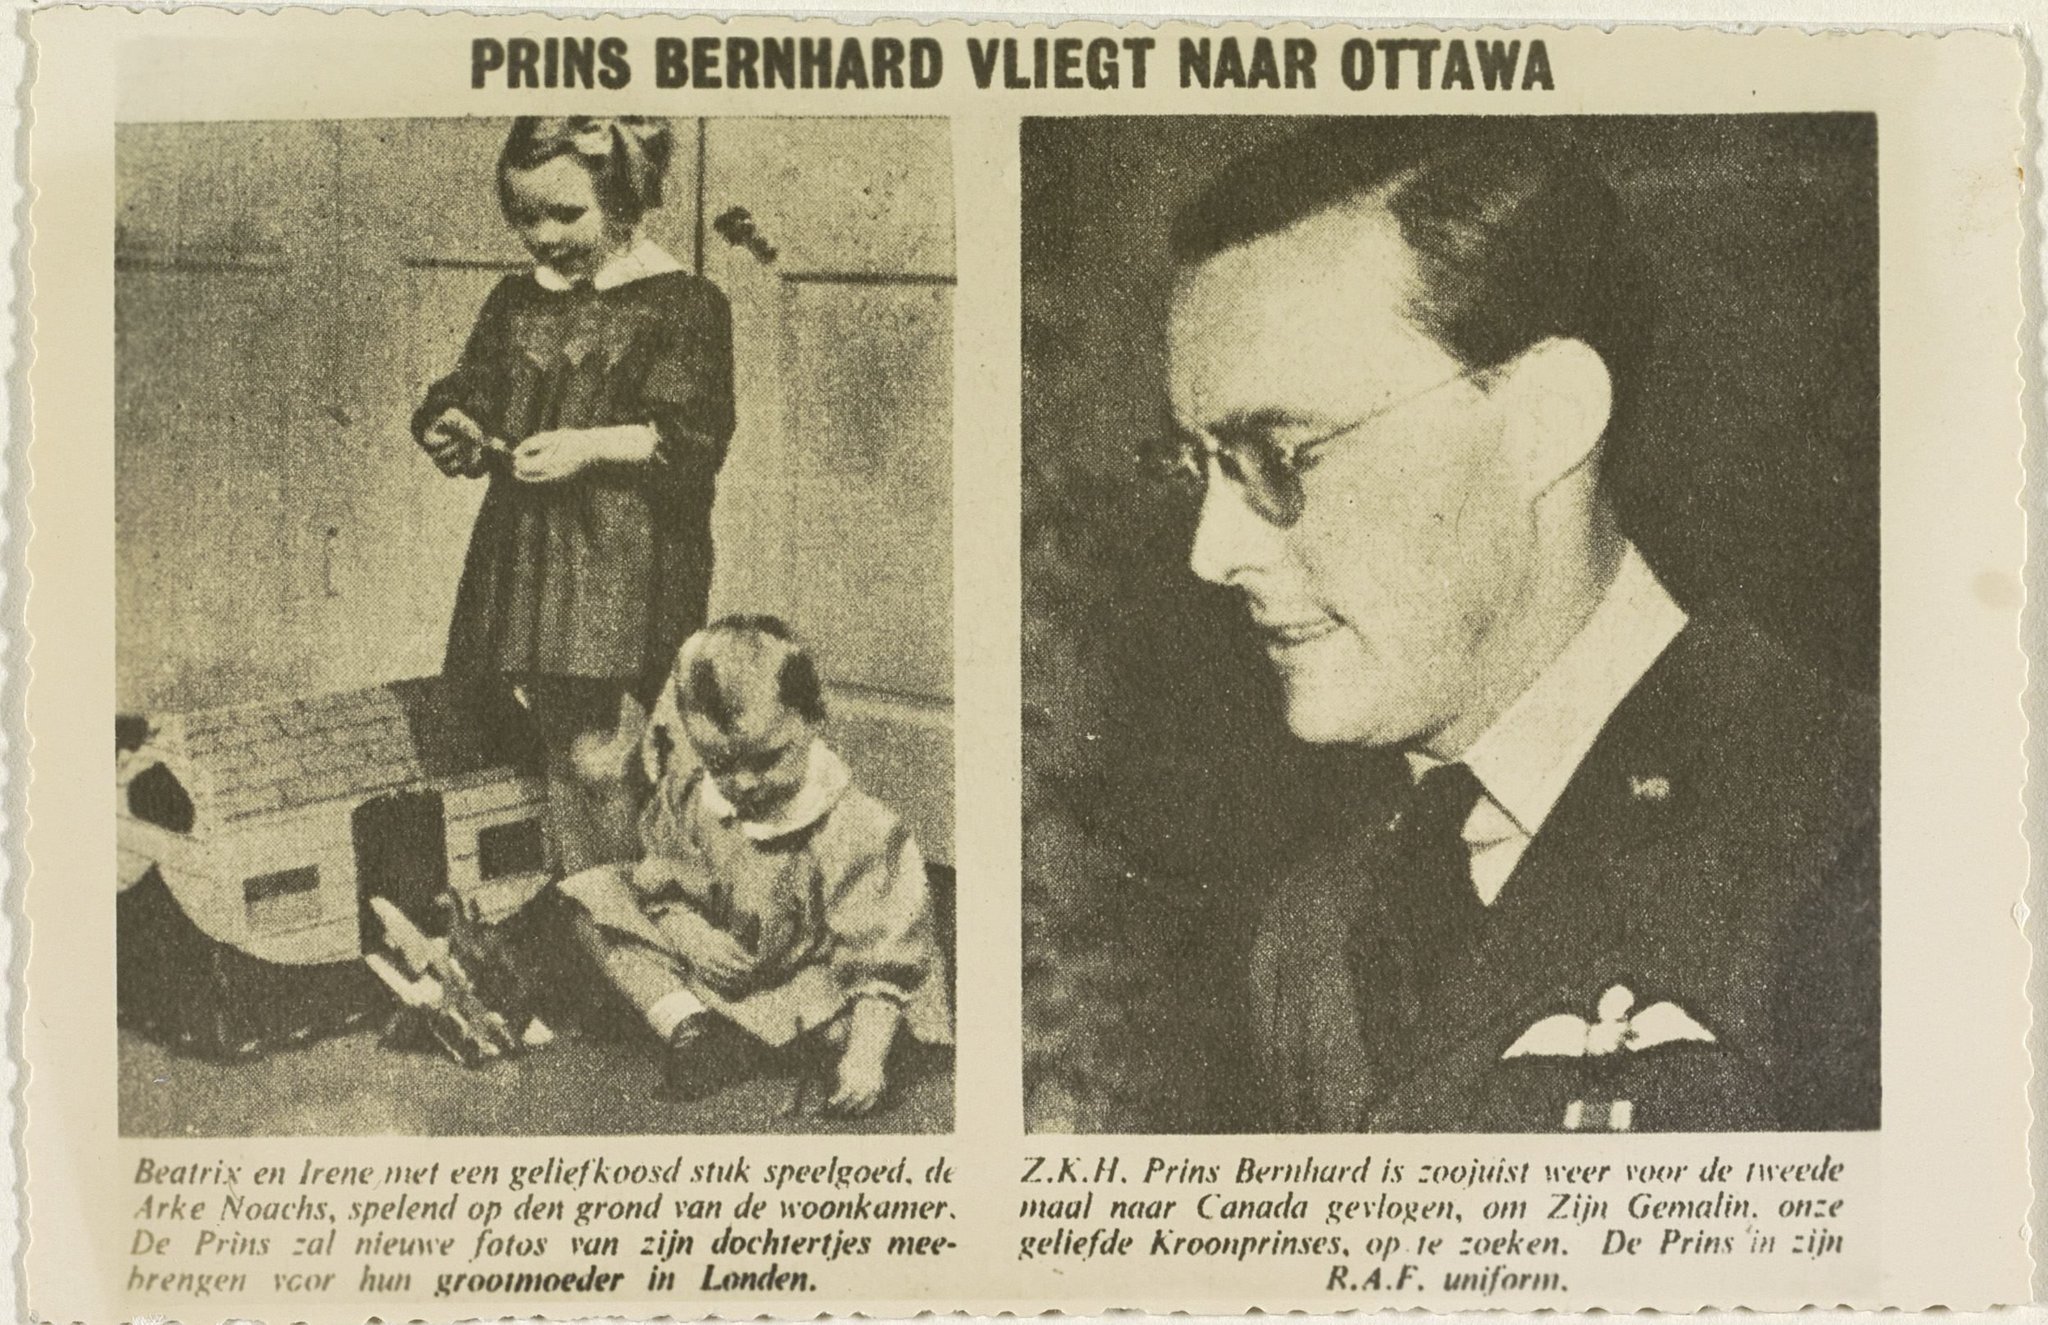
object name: ansichtkaart, prentbriefkaart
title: Portretten van Bernhard van Lippe-Biesterfeld, Beatrix, koningin der Nederlanden, en Irene, prinses der Nederlanden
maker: Anonymous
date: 1941-1943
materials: photographic support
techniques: photography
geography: netherlands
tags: bernhard (prins der nederlanden), beatrix (koningin der nederlanden)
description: De hier vermelde titel verwijst naar de hoogst verkregen titel van de geportretteerde, niet per se naar de titel die de geportretteerde op deze voorstelling draagt. Foto naar een rotogravure naar twee foto's.